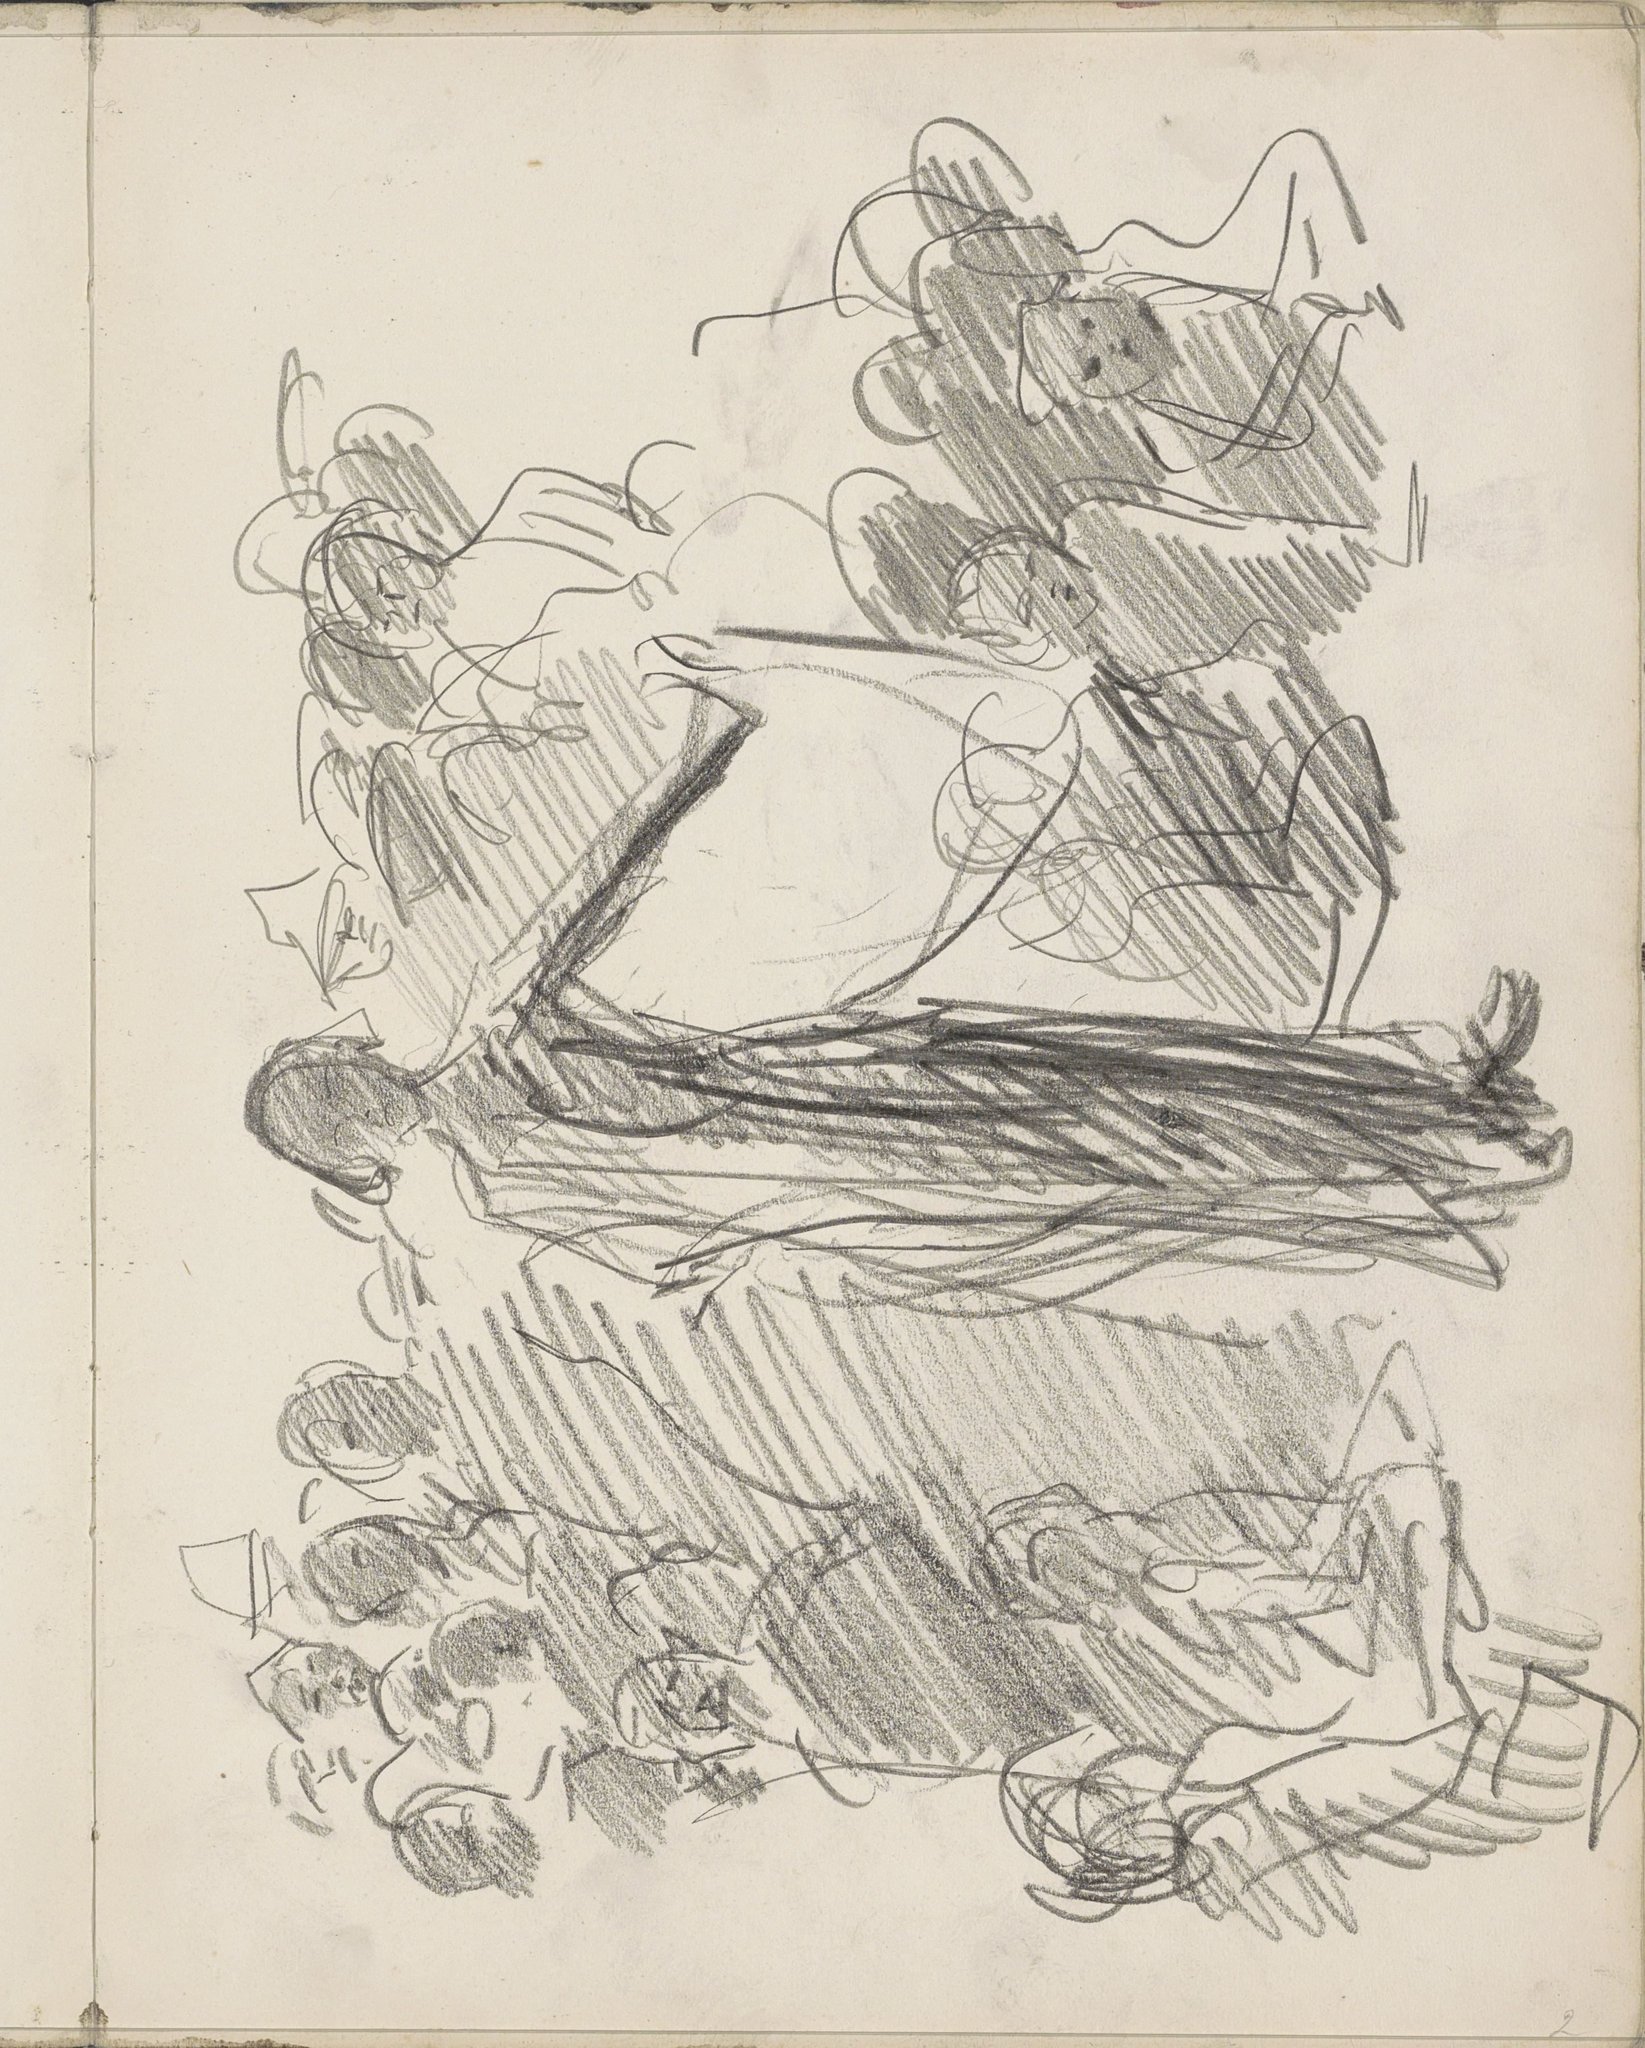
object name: sketchbook leaf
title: Toeschouwers bij een danseres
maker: isaac israels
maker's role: draughtsman, painter, print maker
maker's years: 1865-1934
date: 1921-1922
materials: chalk, paper, pencil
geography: dutch east indies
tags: asiatic races and peoples, the audience ~ art performance, female dancer, dutch east indies, the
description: Blad 2 recto uit schetsboek XIX met 22 bladen.